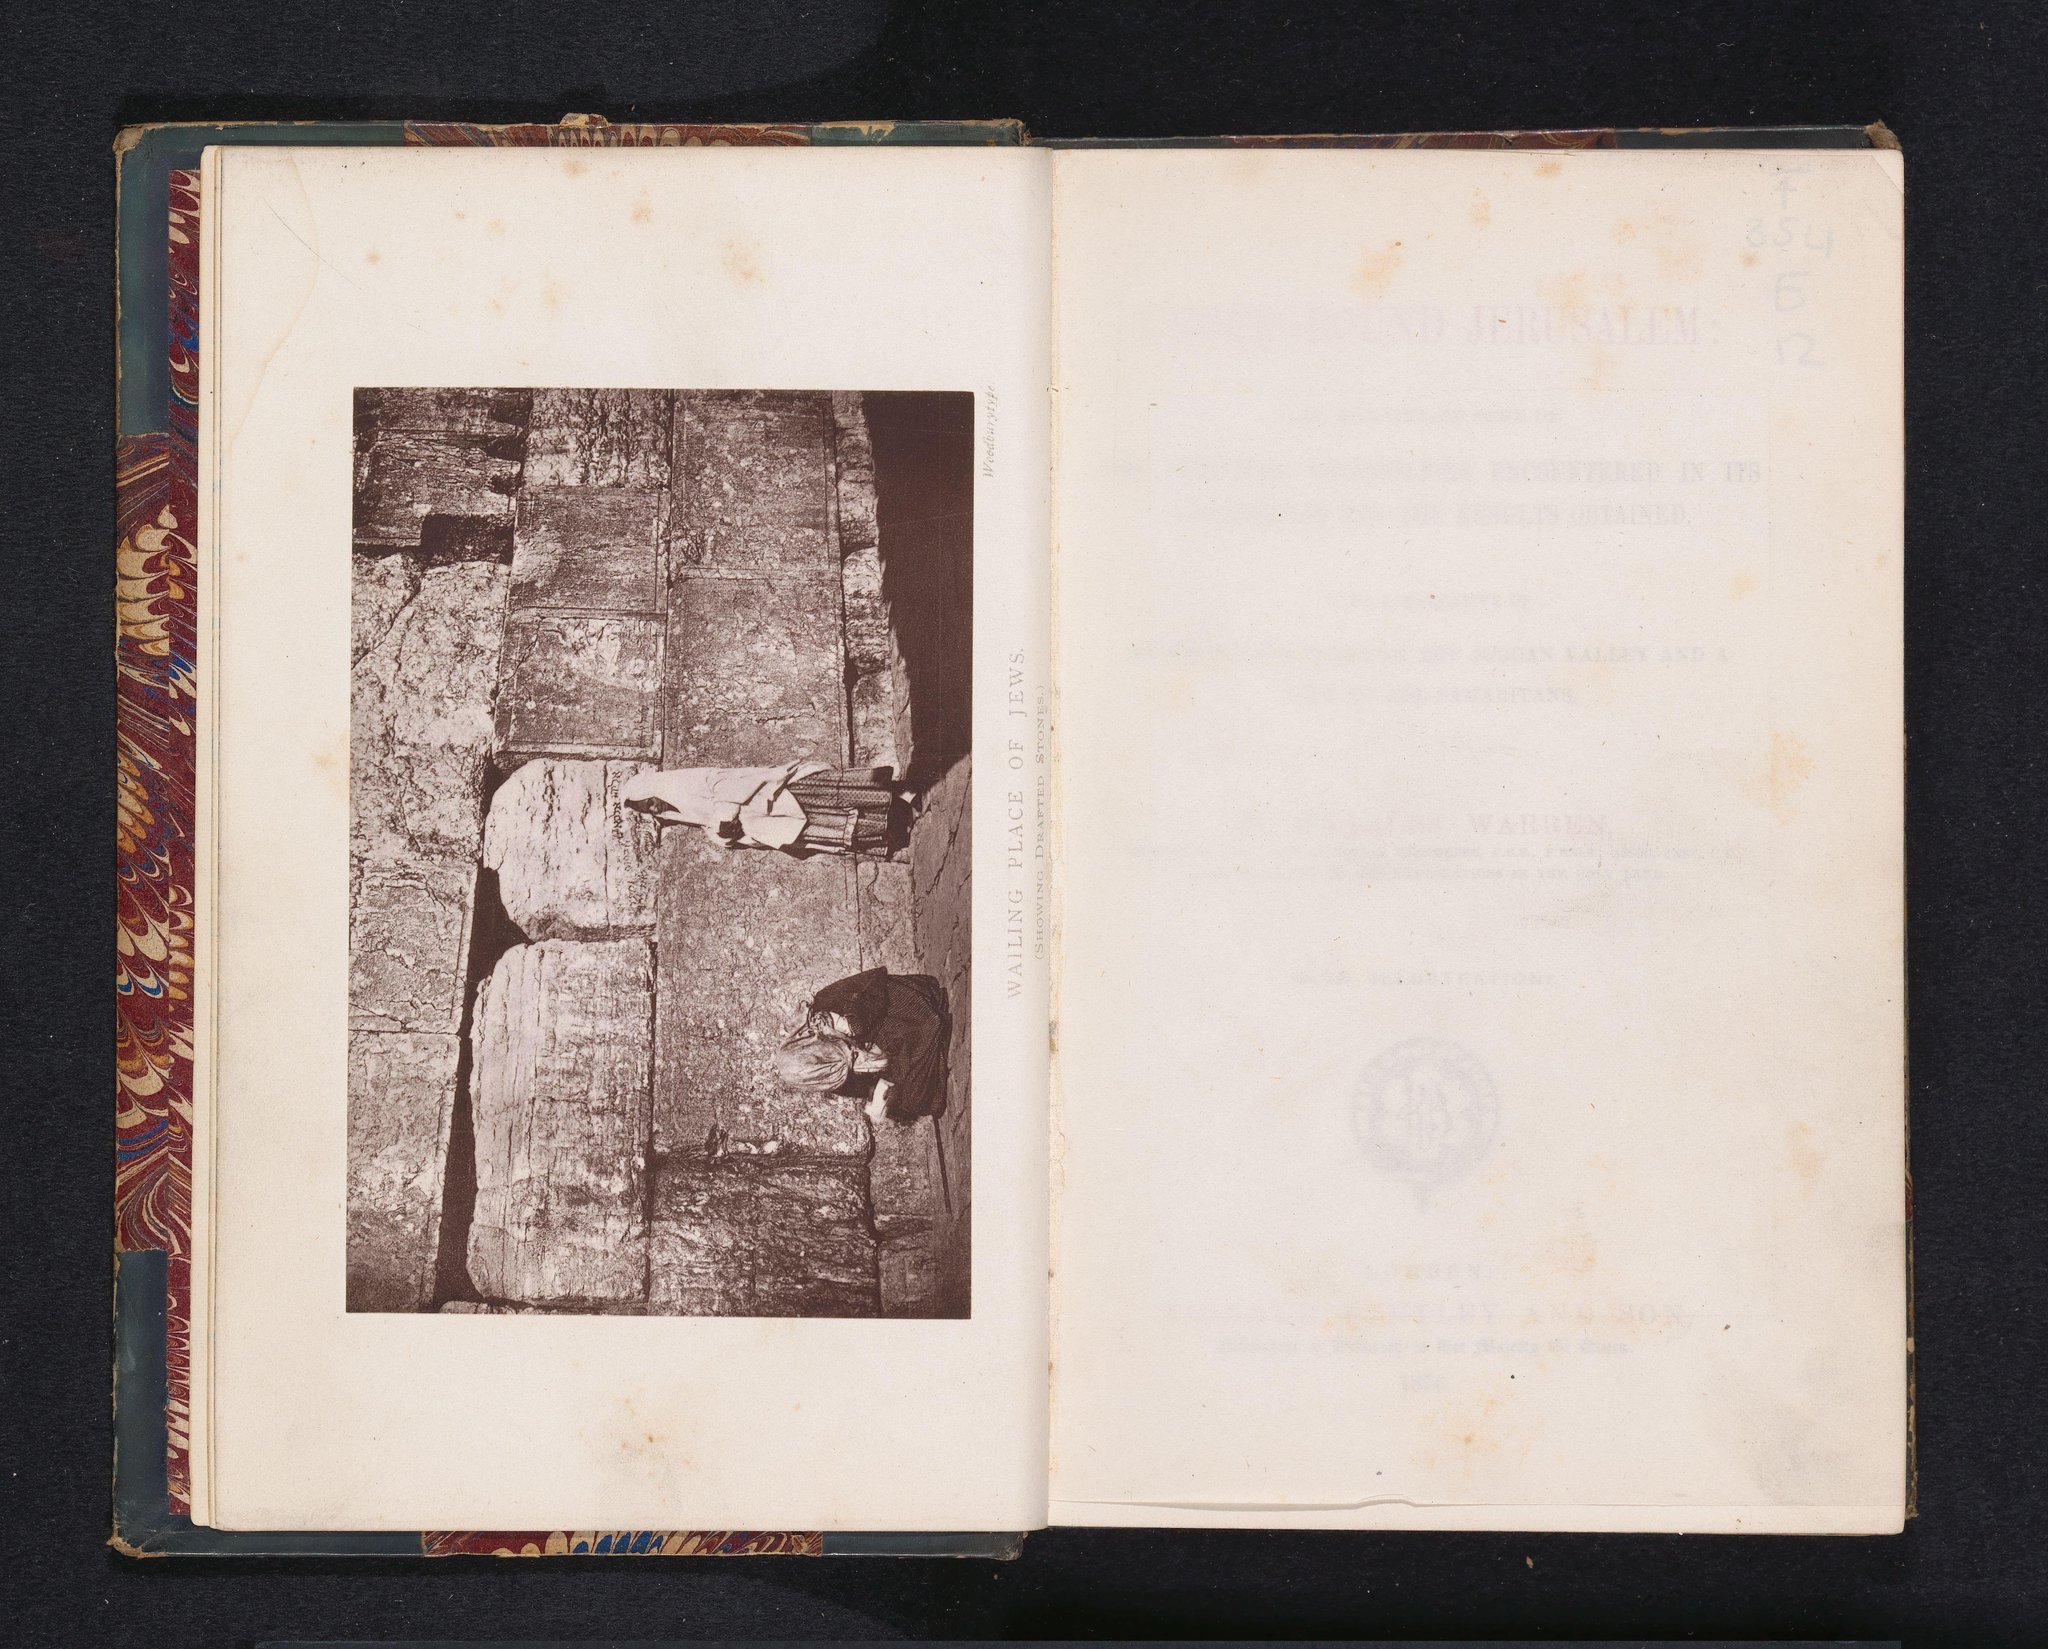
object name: photomechanical print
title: Wailing Place of Jews (showing drafted stones)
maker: Anonymous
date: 1871-1876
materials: paper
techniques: woodburytype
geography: jerusalem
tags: wailing wall ~ jewish religion, the jews, jewish life